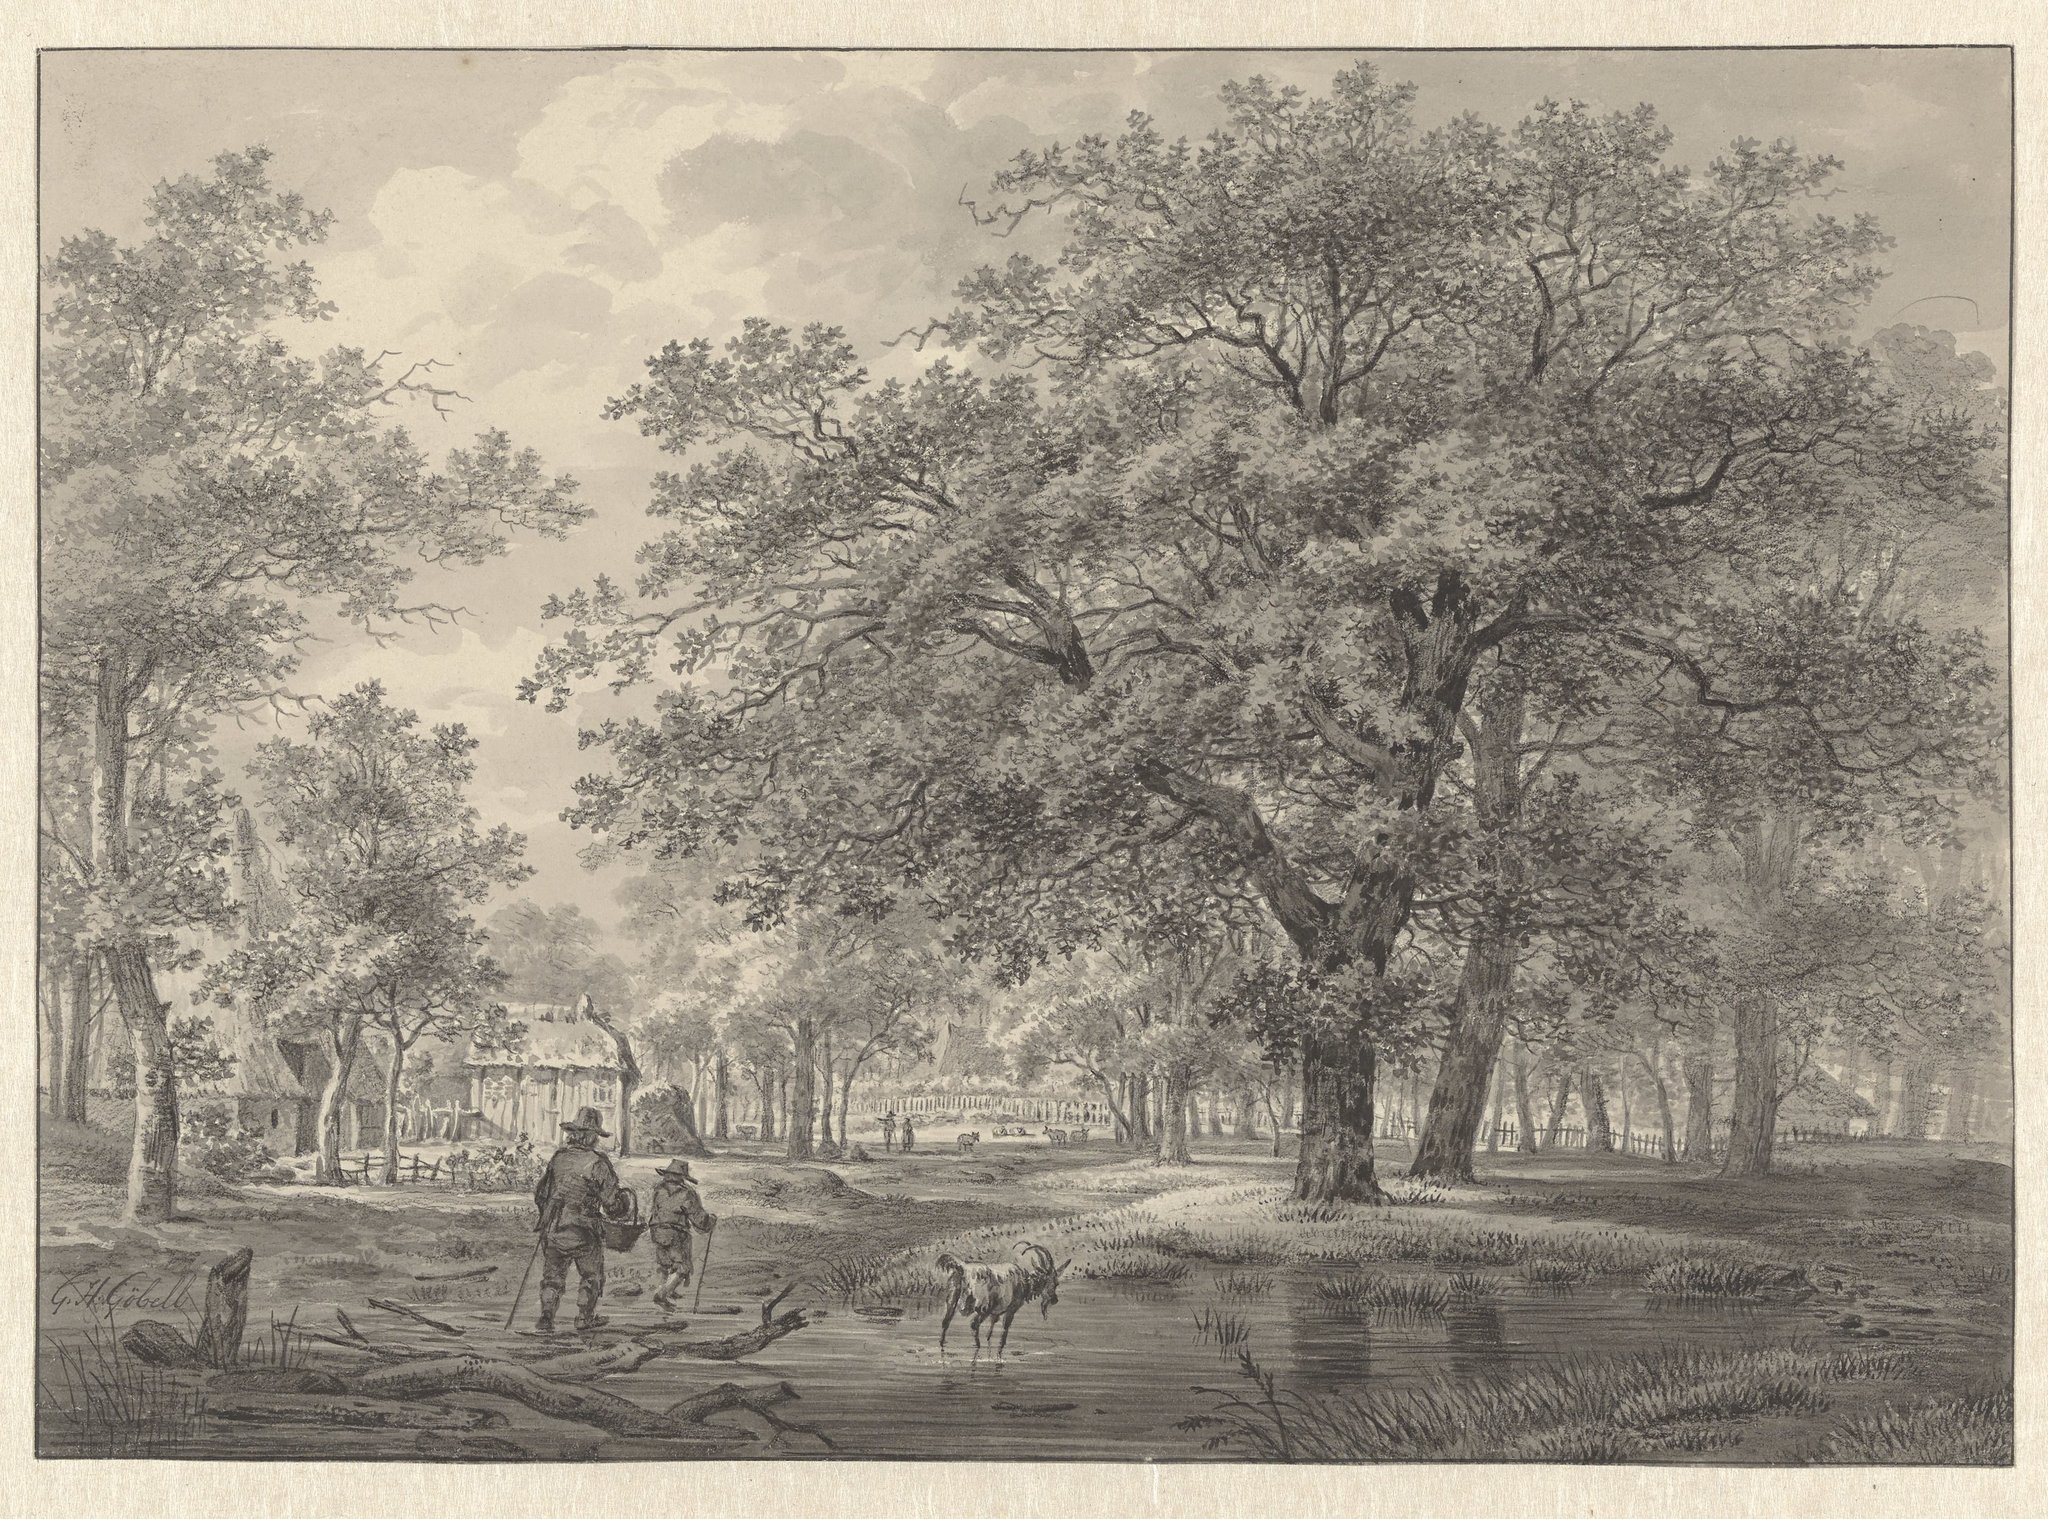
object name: drawing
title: Gezicht te Emmen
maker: gerrit hendrik gobell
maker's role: draughtsman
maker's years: 1786-1833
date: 1832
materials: chalk, paper, pencil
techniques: brush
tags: prospect of village, silhouette of village